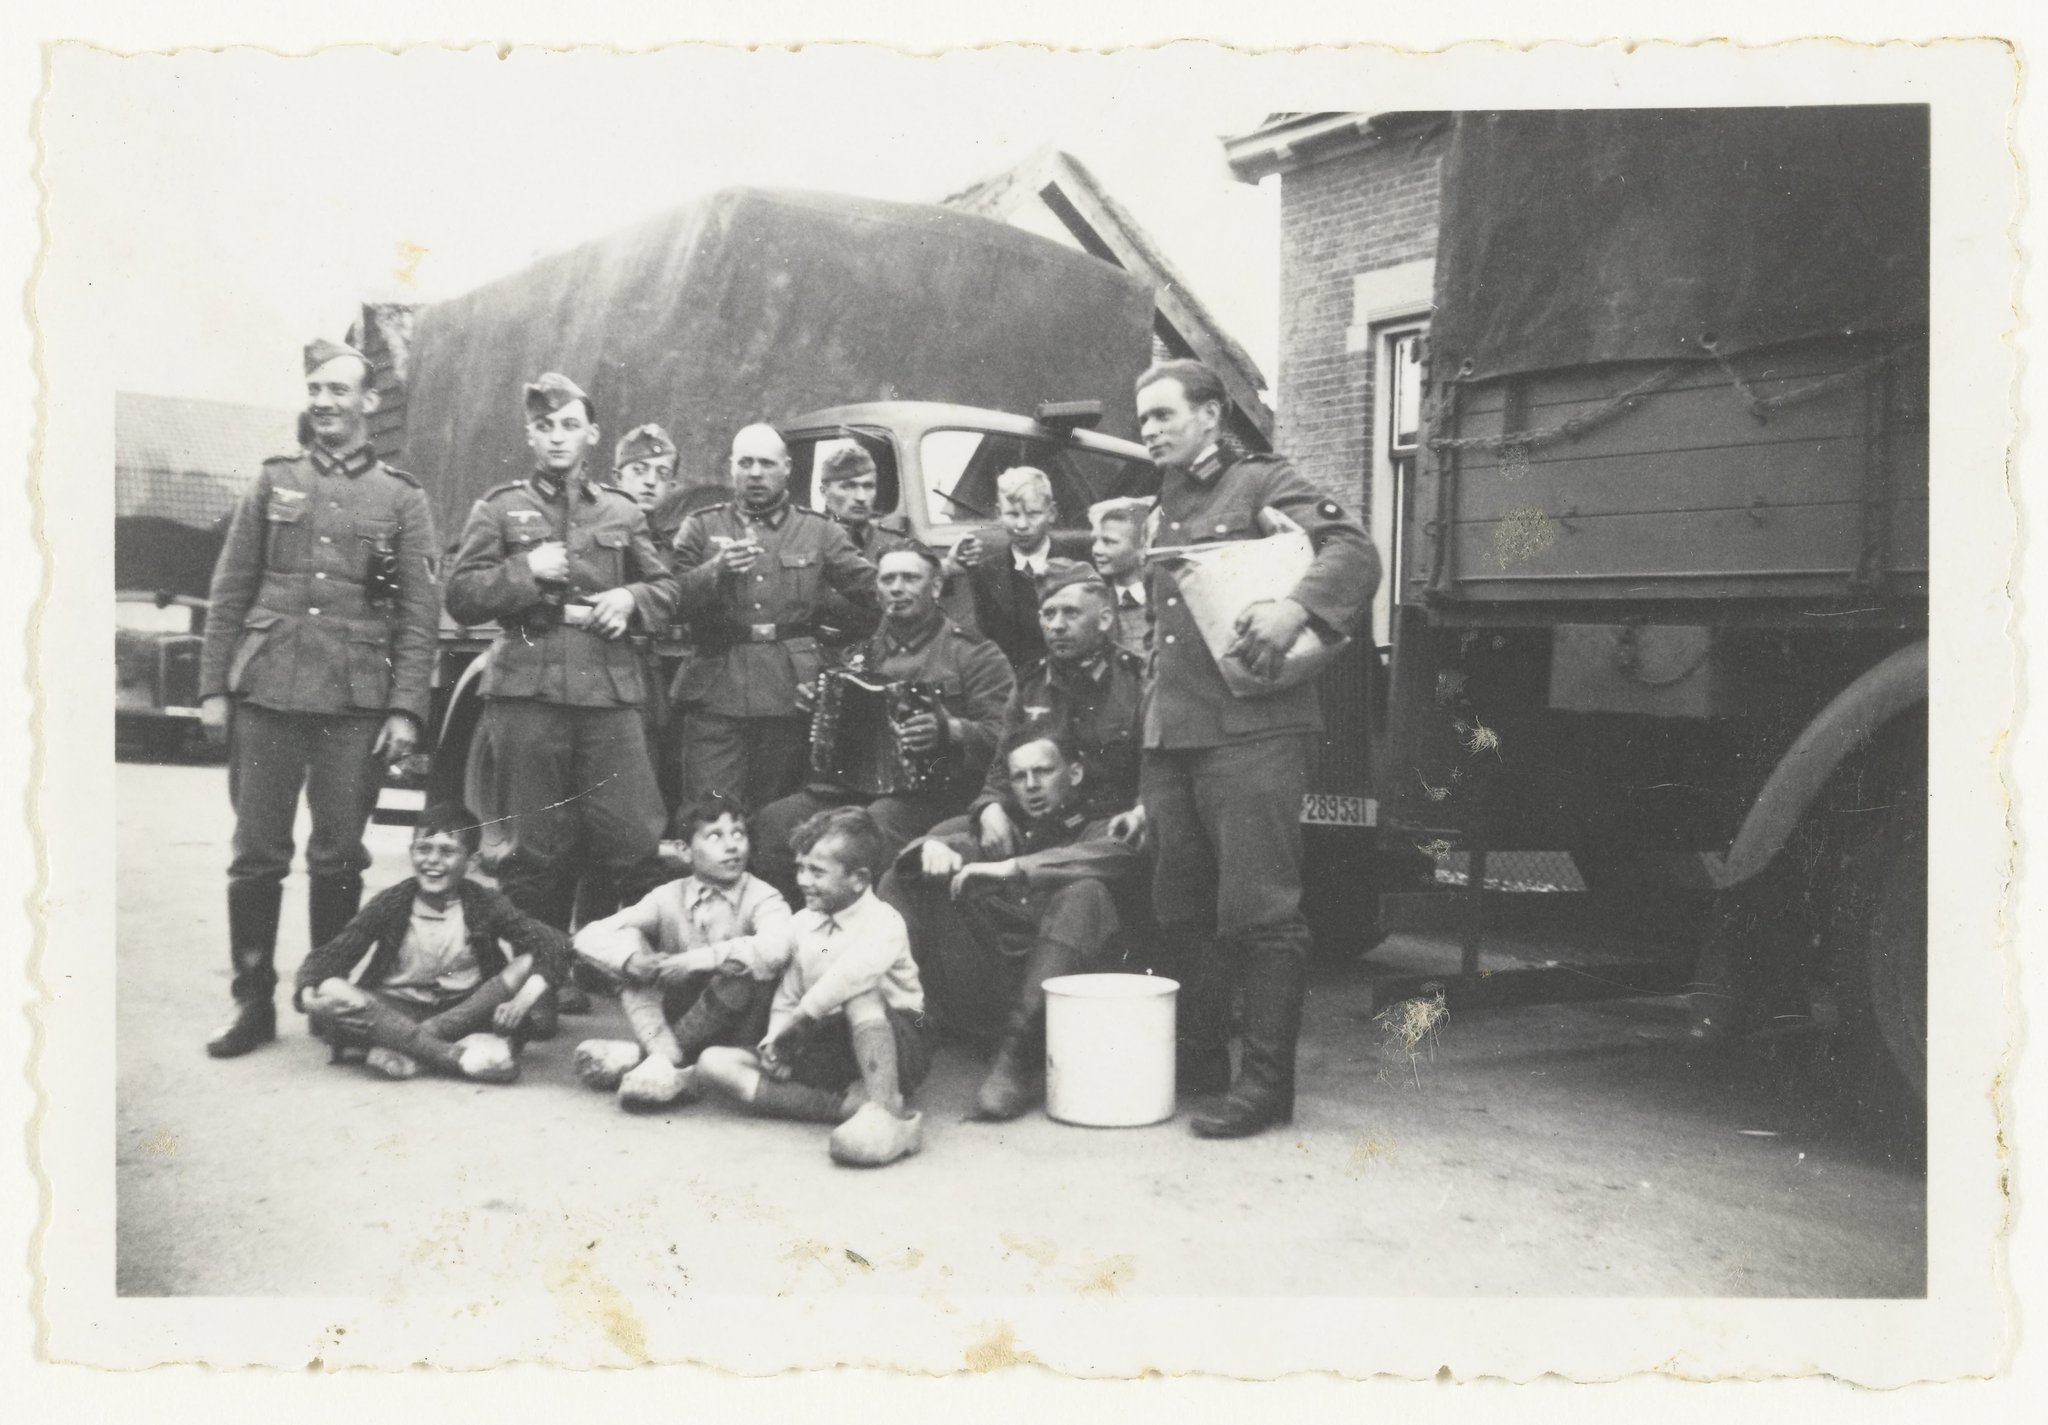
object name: photograph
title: Wehrmachtsoldaten met Nederlandse jongetjes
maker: Anonymous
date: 1941-1942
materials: photographic support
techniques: gelatin silver print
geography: netherlands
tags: occupier and civilians, occupation ~ war, netherlands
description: Een groep Wehrmacht militairen staan voor twee legertrucks. Een speelt op een harmonika. Voor hen zitten drie Nedelandse jongetjes met klompen aan. Achteraan staan er nog twee.